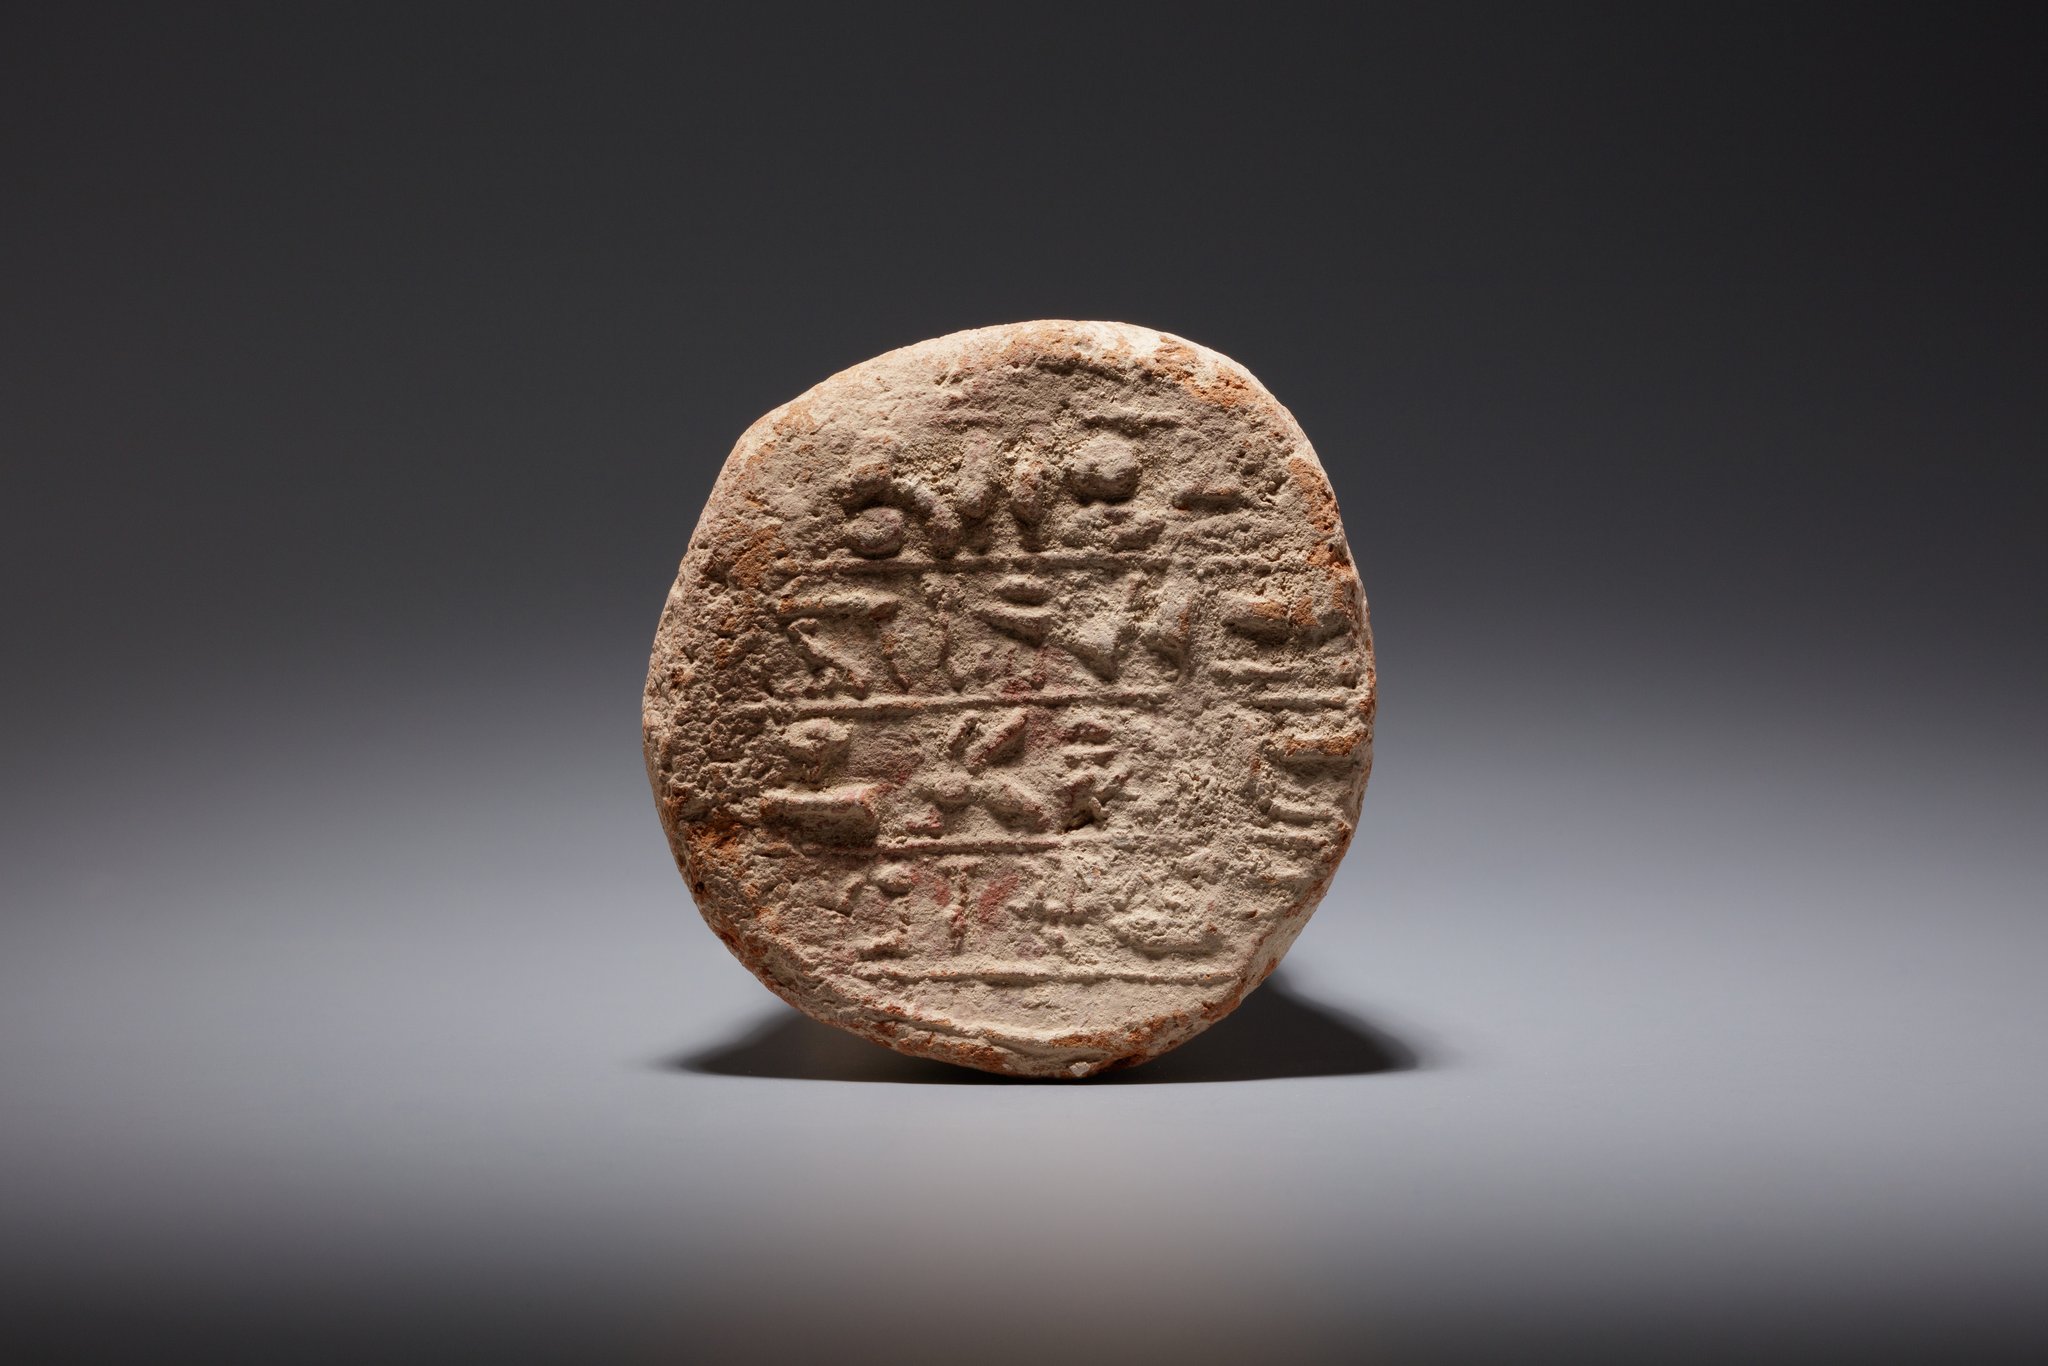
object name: cone, davy 405, neferkhawet, wab priest, bee keeper, amun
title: Funerary Cone of the Wab-Priest Neferkhawet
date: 1550-1295 BCE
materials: pottery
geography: egypt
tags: hieroglyphs